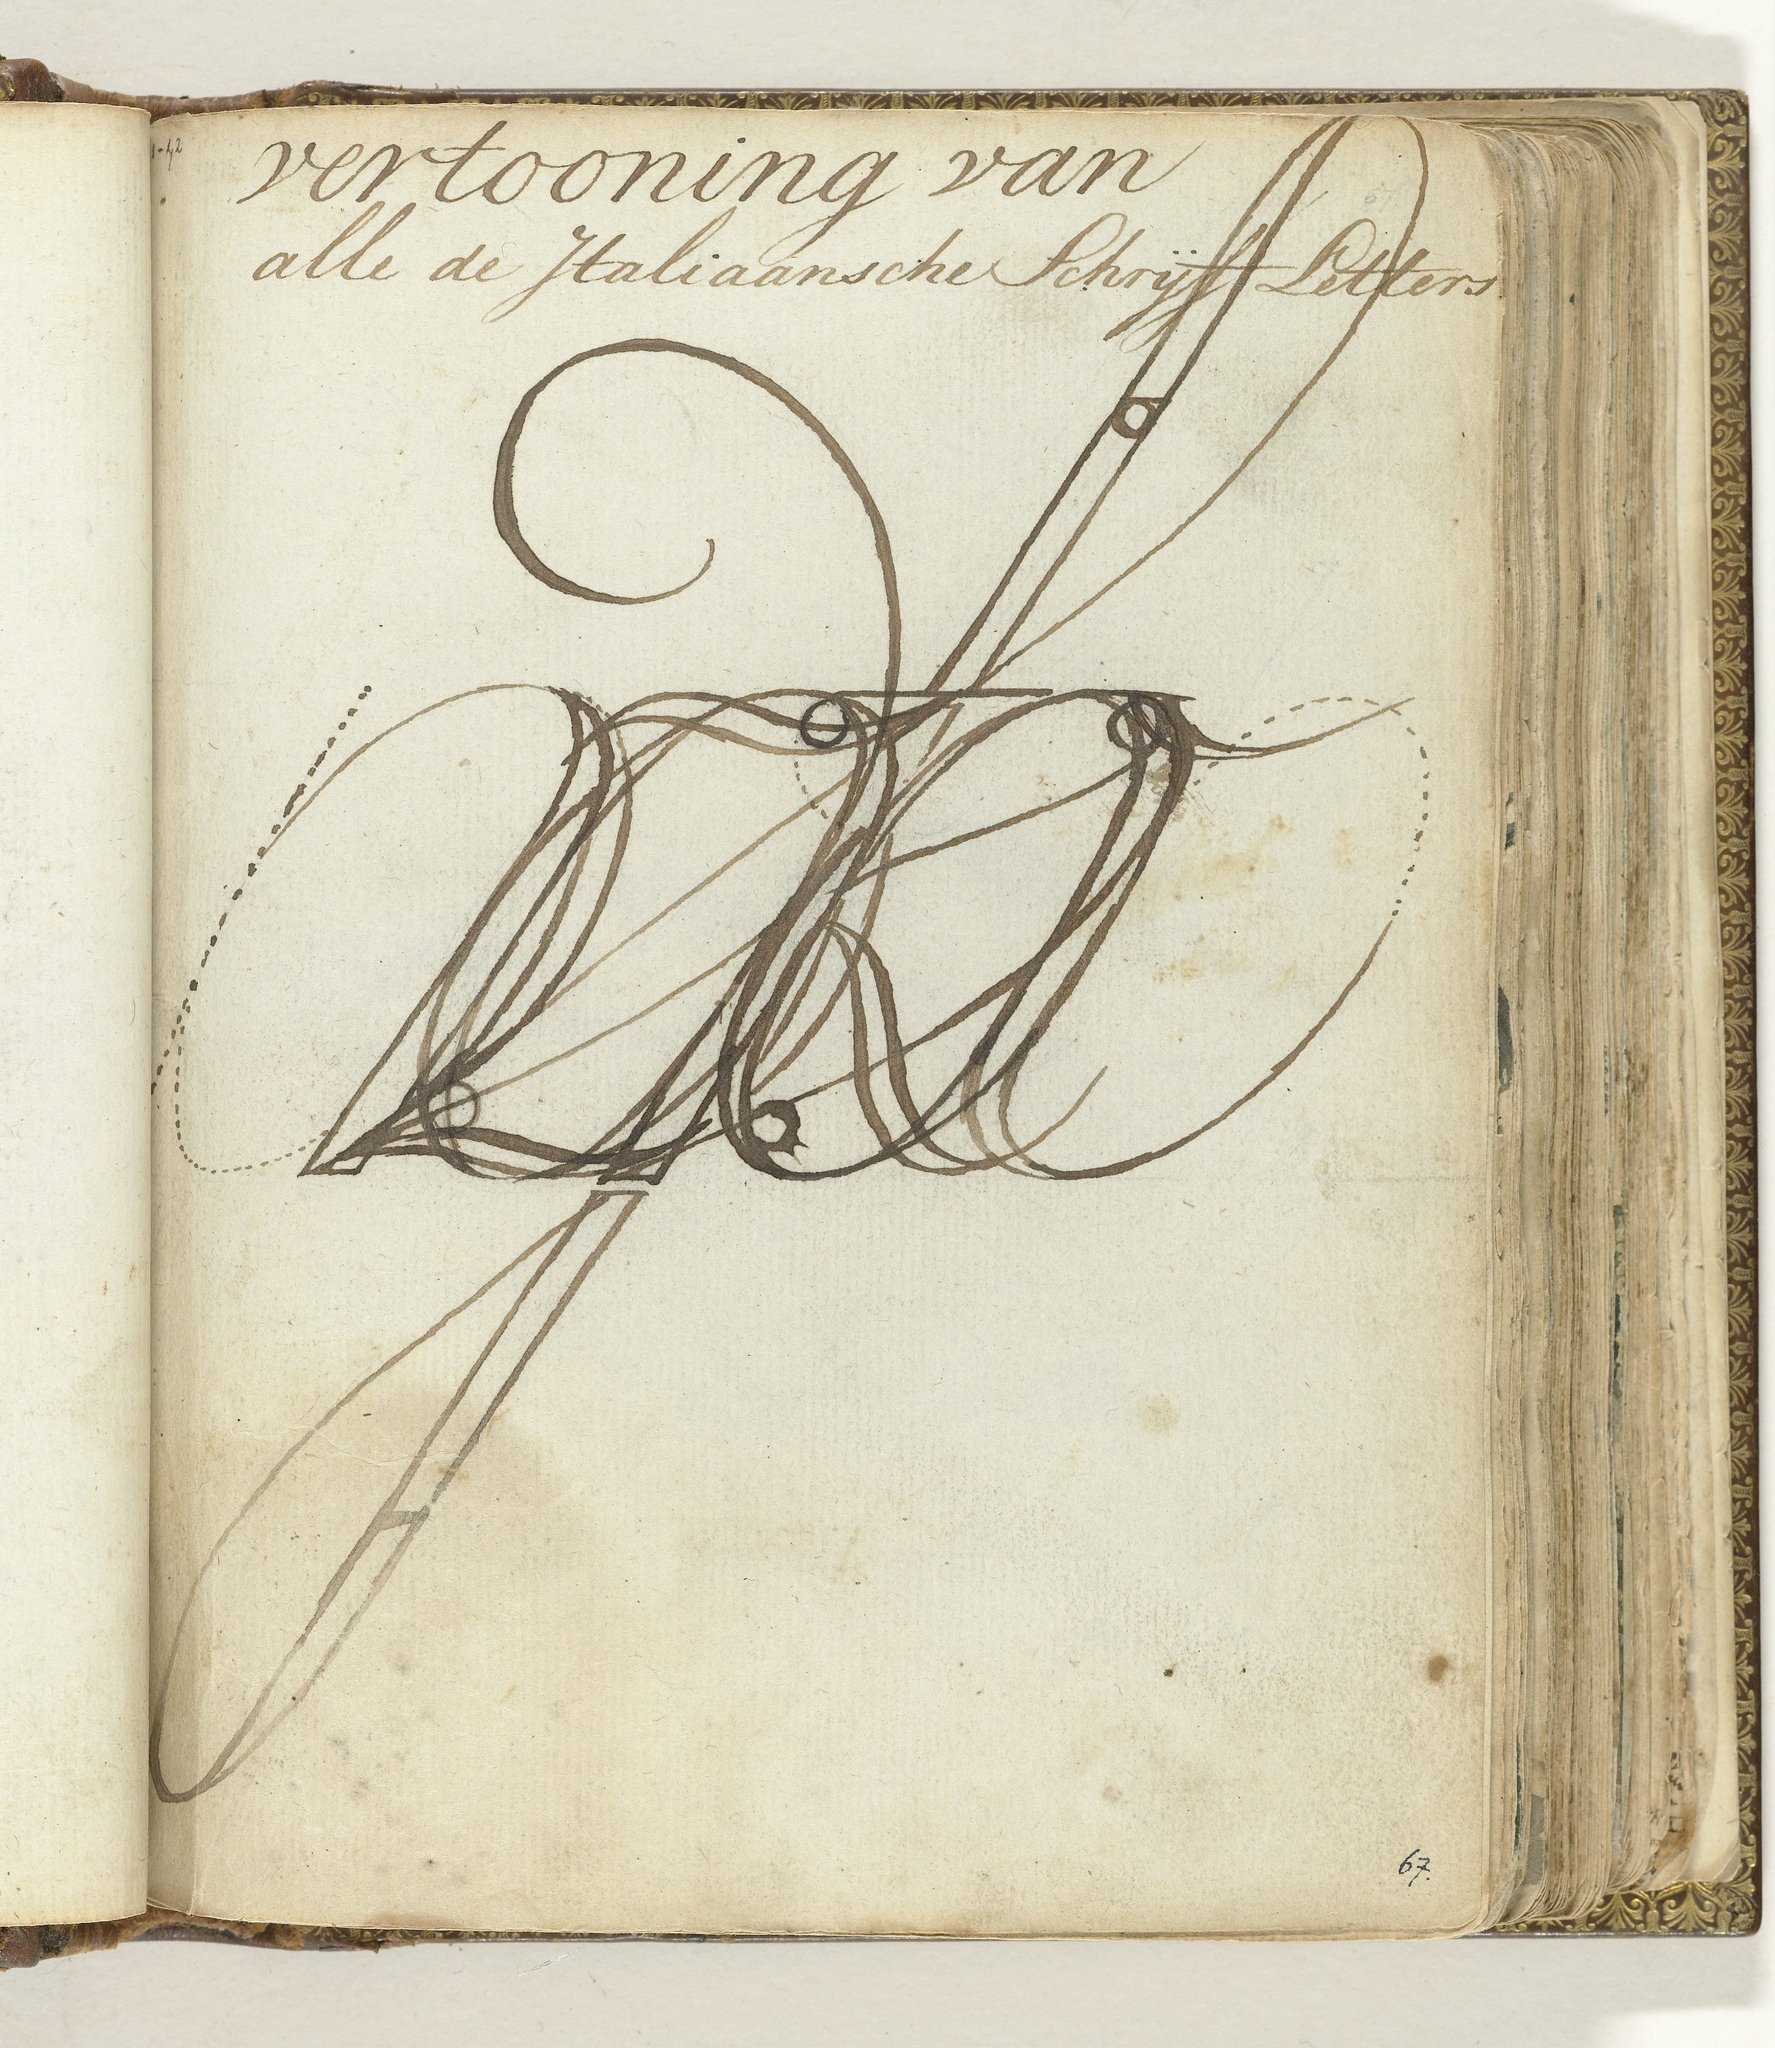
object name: calligraphy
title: Italiaanse schrijfletters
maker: jan brandes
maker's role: draughtsman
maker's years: 1743-1808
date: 1770-1808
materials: ink, paper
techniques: pen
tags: calligraphy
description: Pentekening: 'vertooning van alle de Italiaanse Schrijfletters'. De lettters zijn alle over elkaar getekend tot éen figuur. Denkelijk overgenomen uit een boek. Onderdeel uit het schetsboek van Jan Brandes, dl. 1 (1808), p. 67.